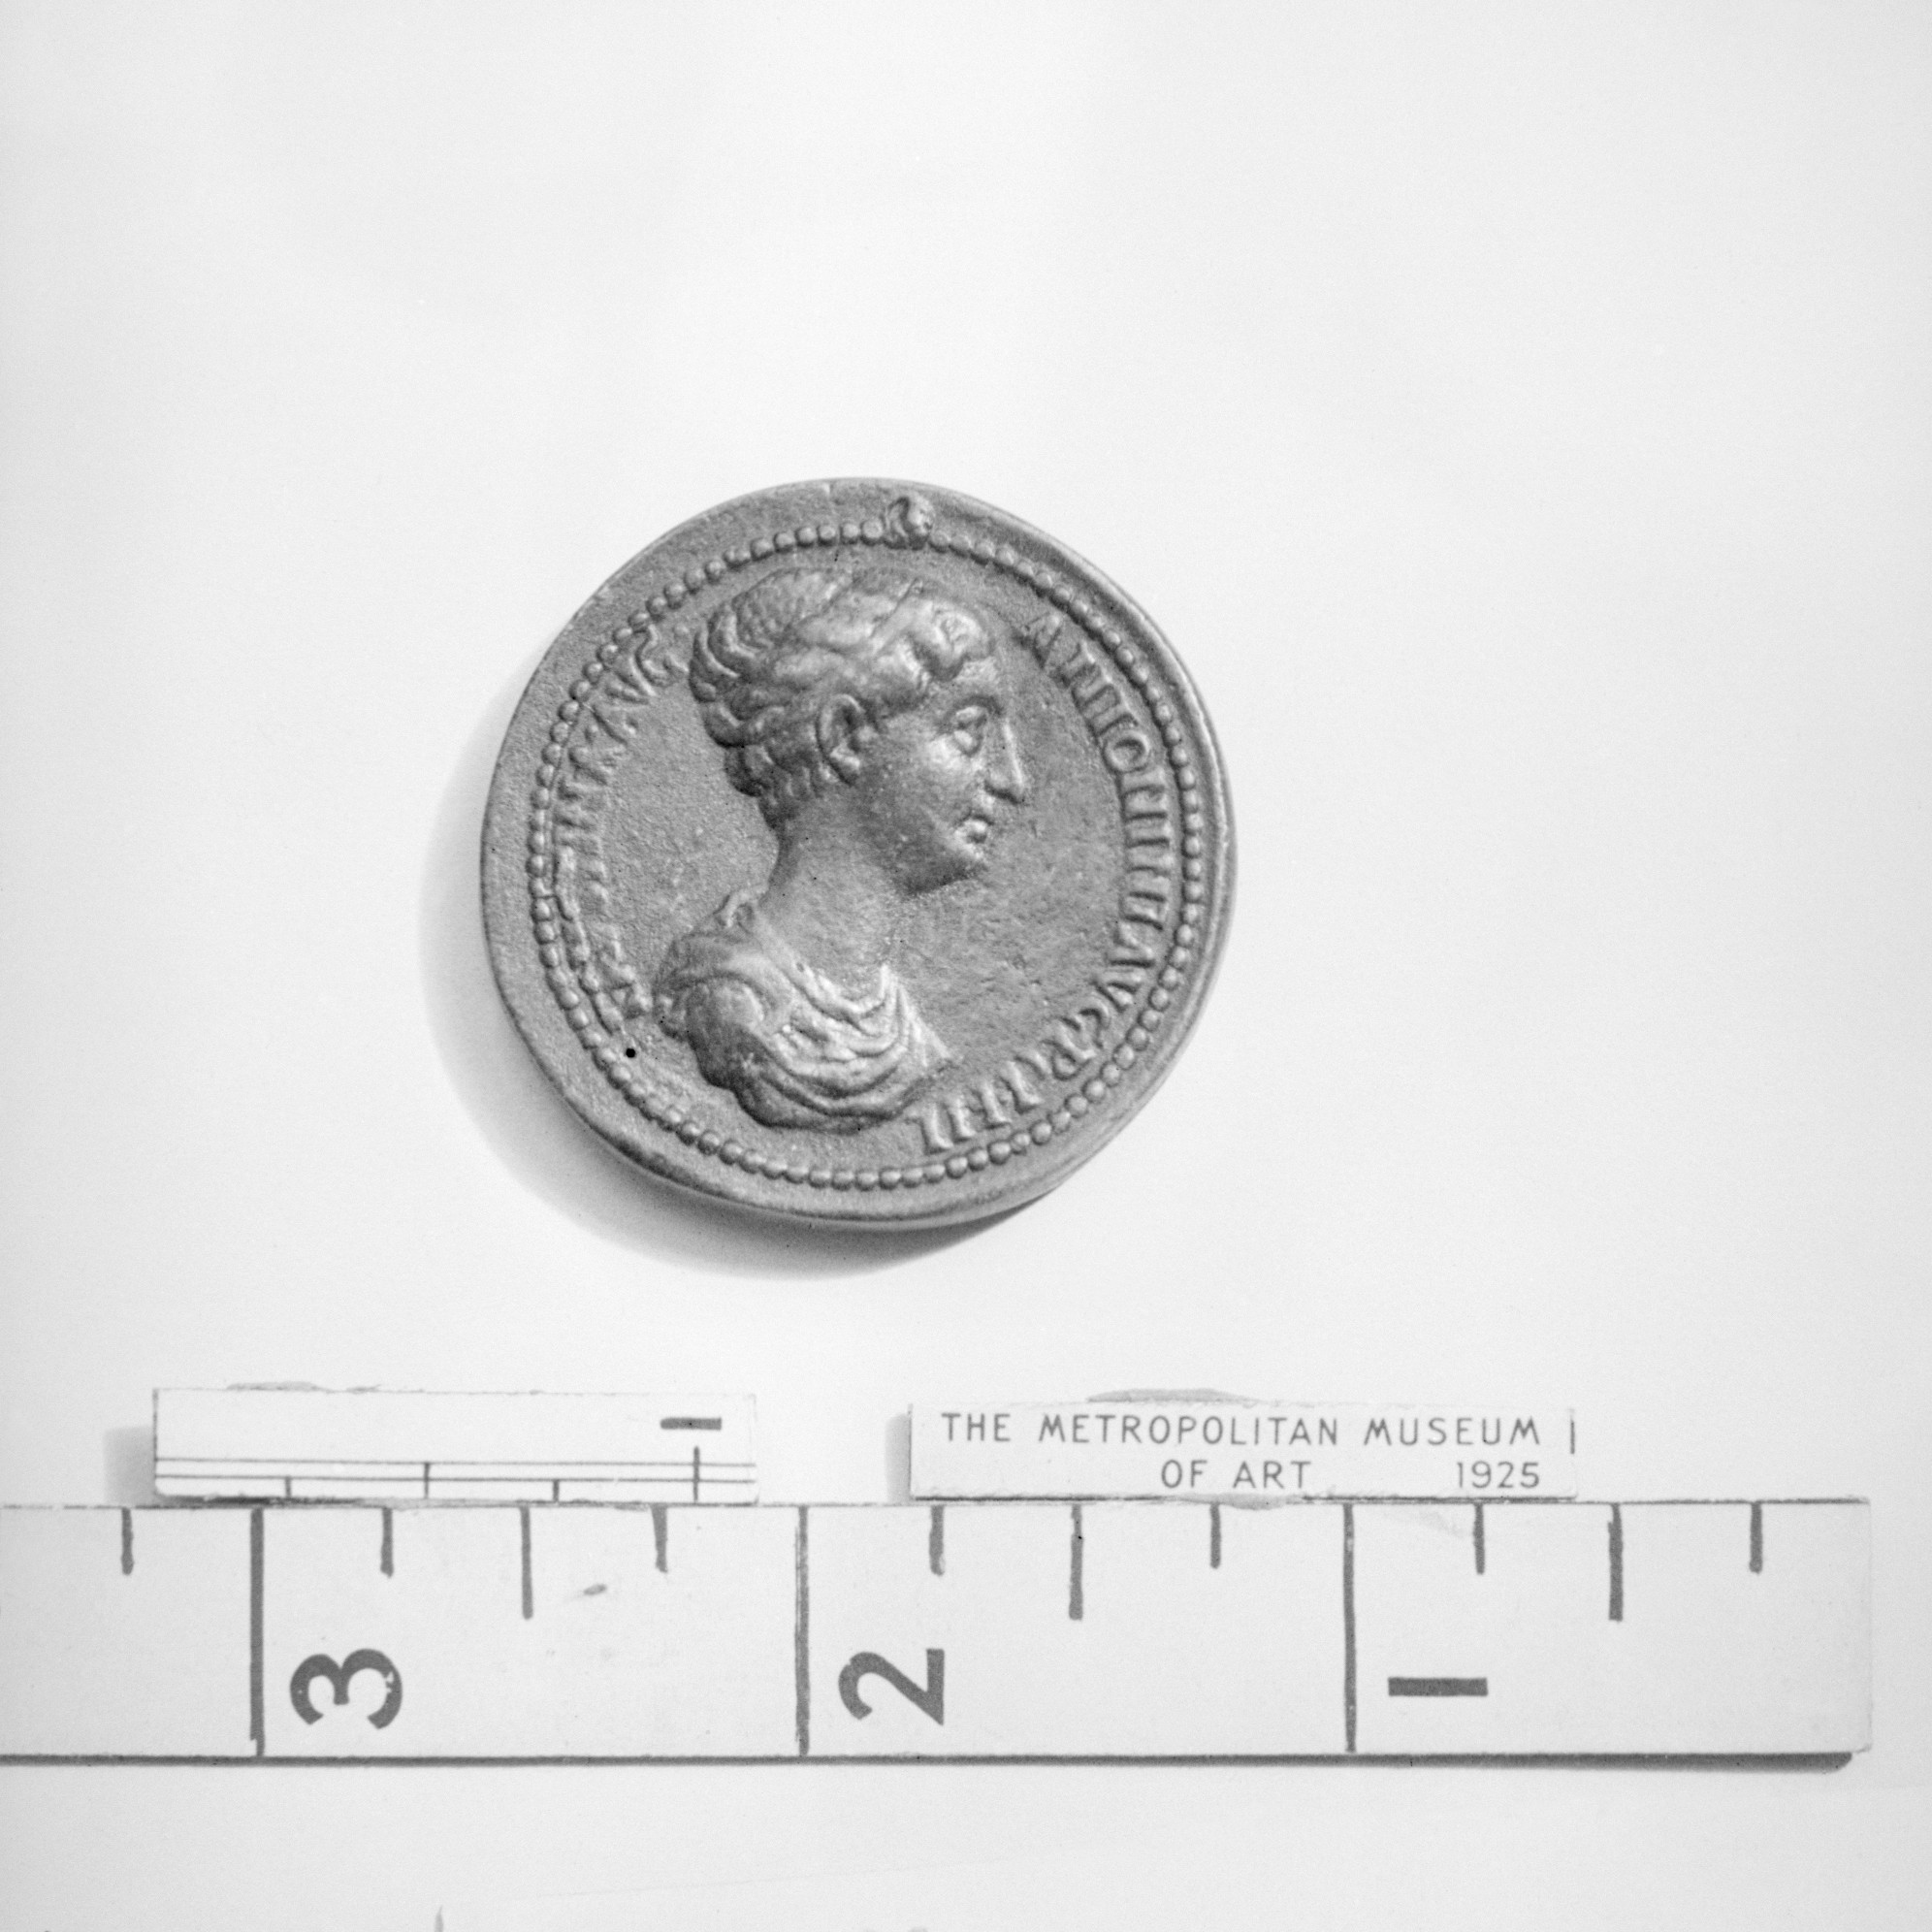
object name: medal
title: Annia Galeria Faustina, wife of Marcus Aurelius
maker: giovanni del cavino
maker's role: artist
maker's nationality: italian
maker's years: 1500-1570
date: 1501-1600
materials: bronze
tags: men,profiles,women